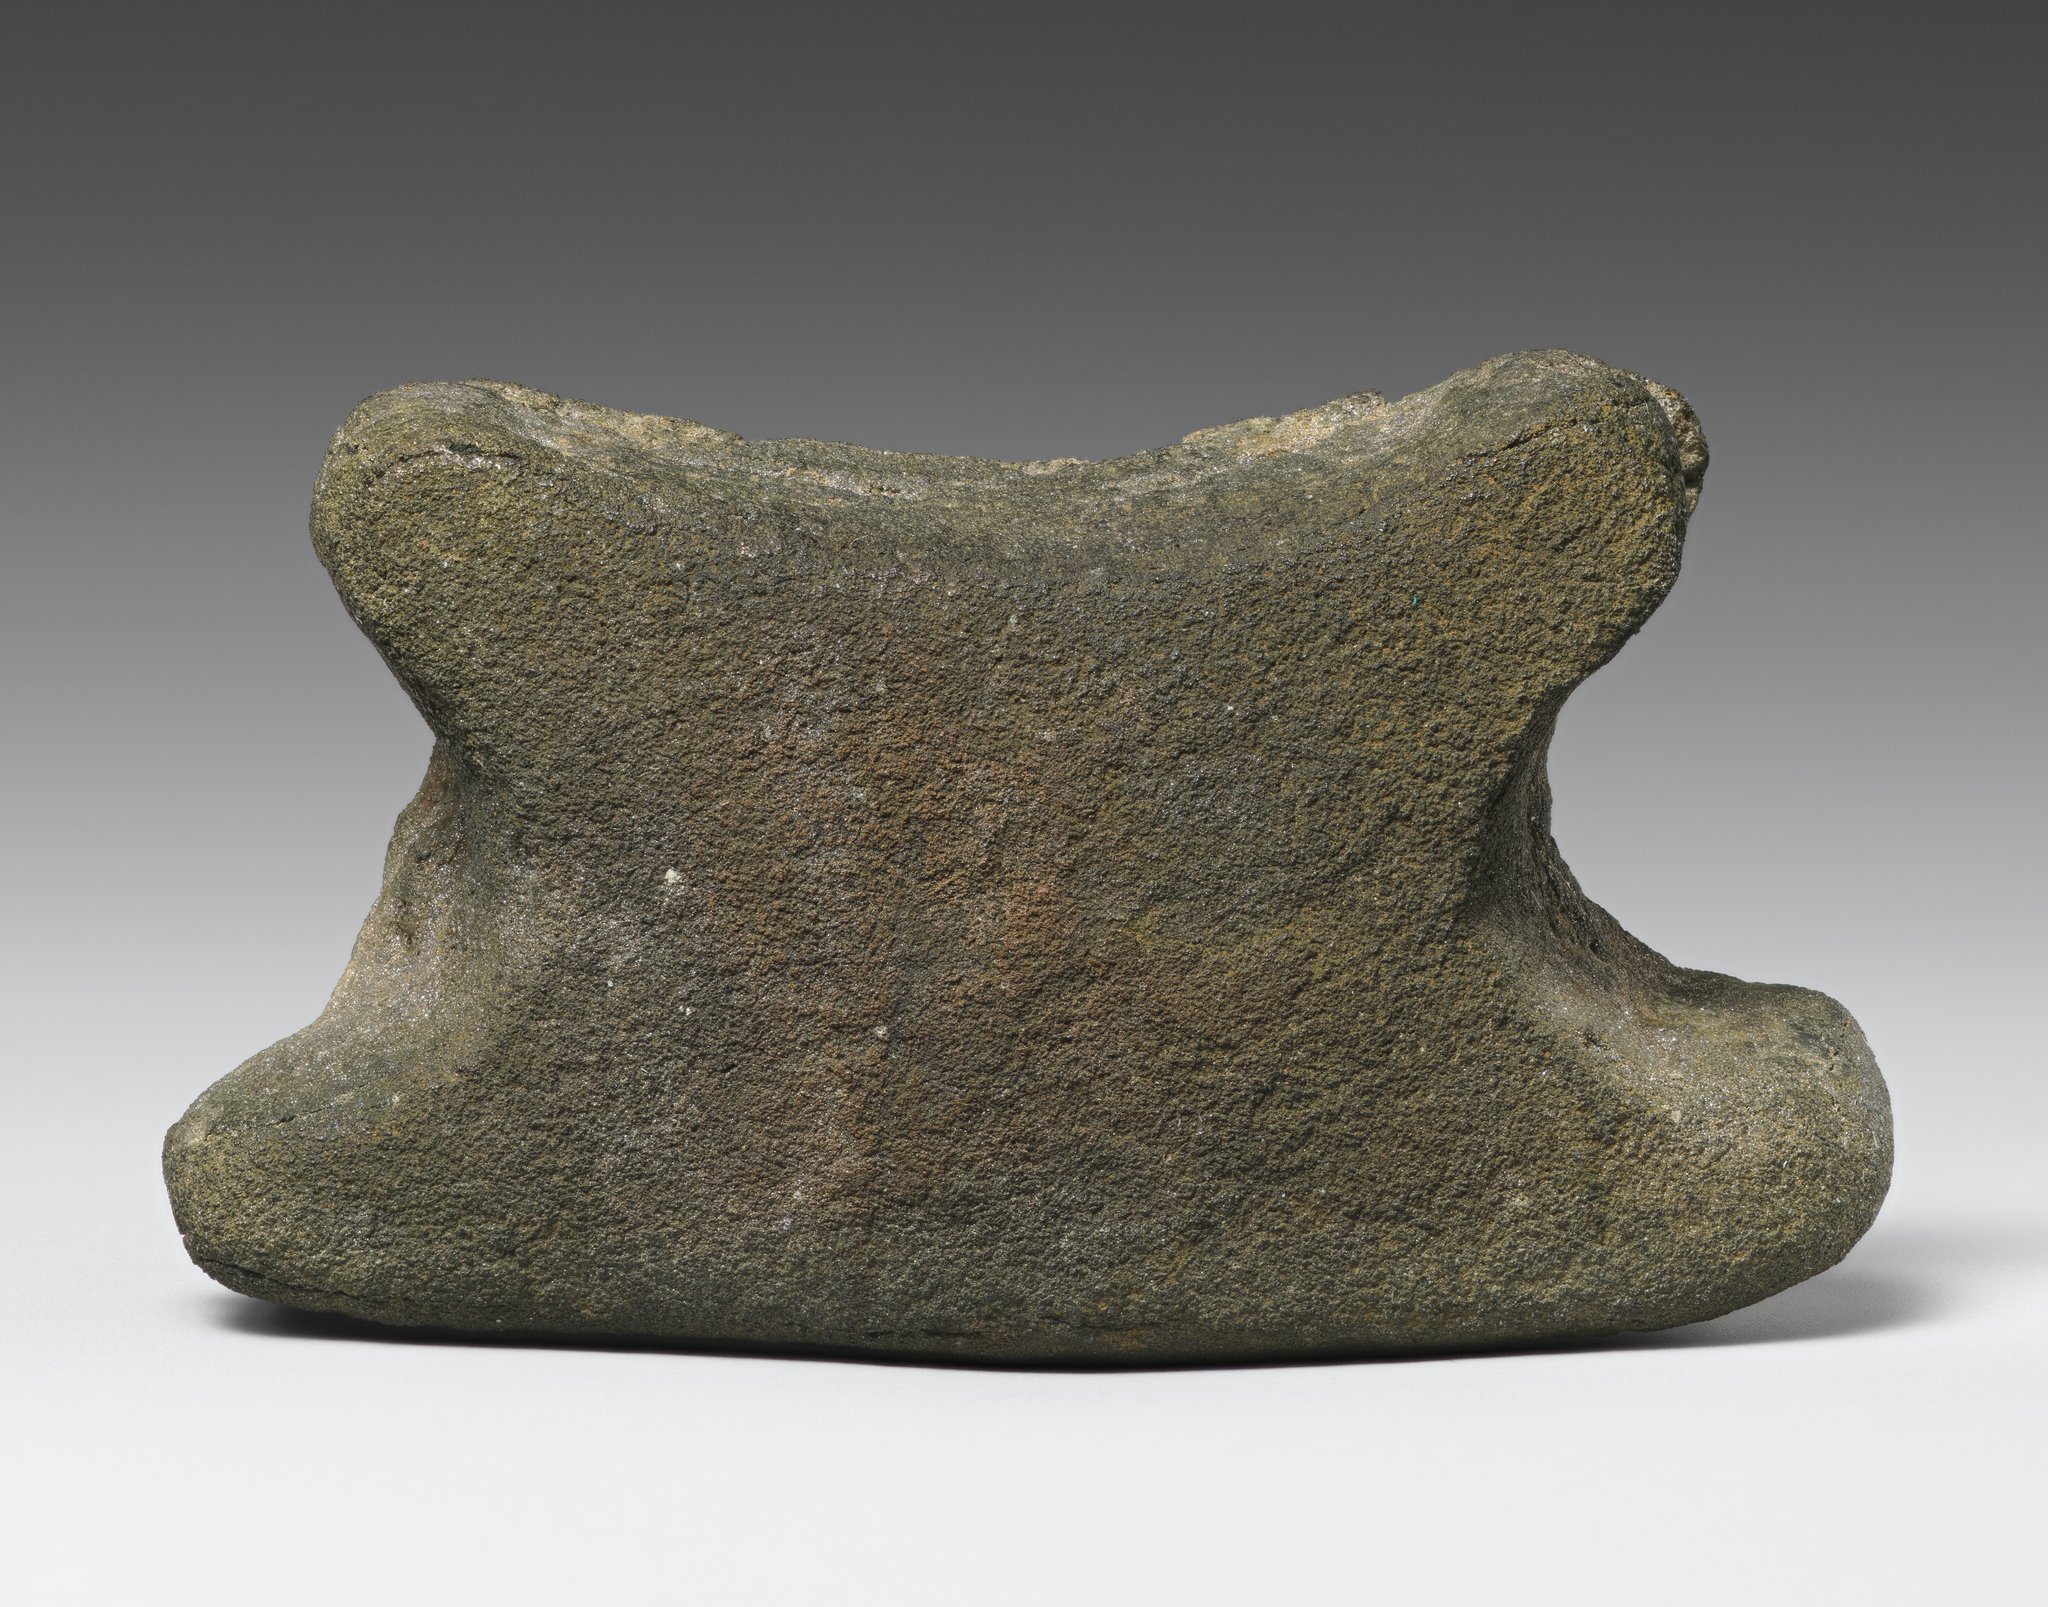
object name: weight, or cramp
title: Weight, or cramp (?)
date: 1550-1295 BCE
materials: lead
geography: egypt